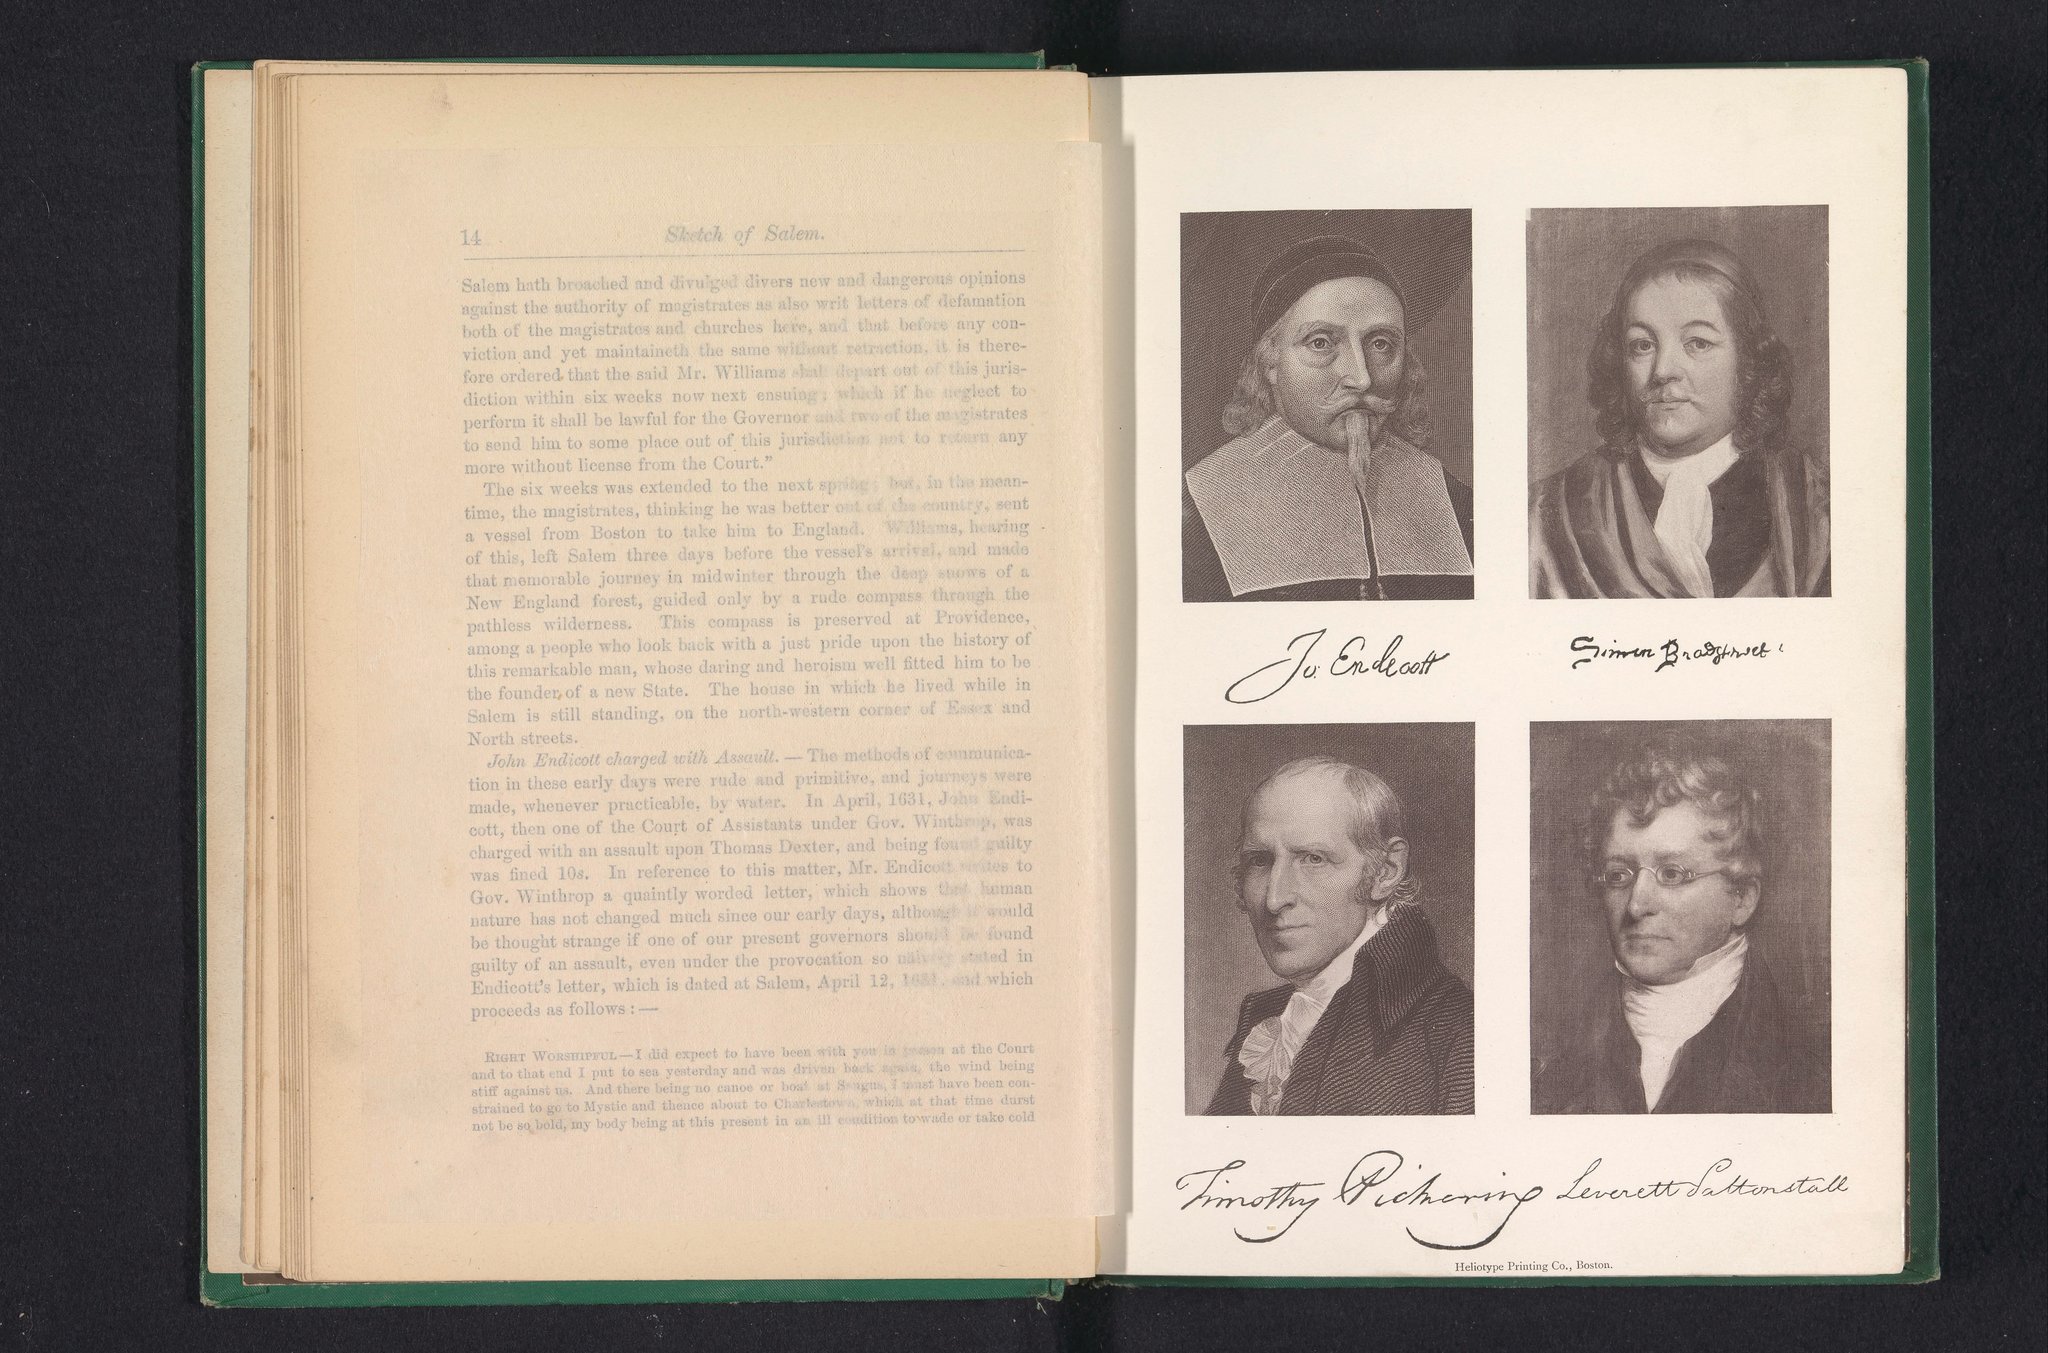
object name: page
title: Jo. Endicott Simon Bradstreet Timothy Pickering Leverett Saltonstall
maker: Anonymous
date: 1869-1879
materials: paper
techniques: photoaquatint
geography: boston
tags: politician, politician, e.g. party leader